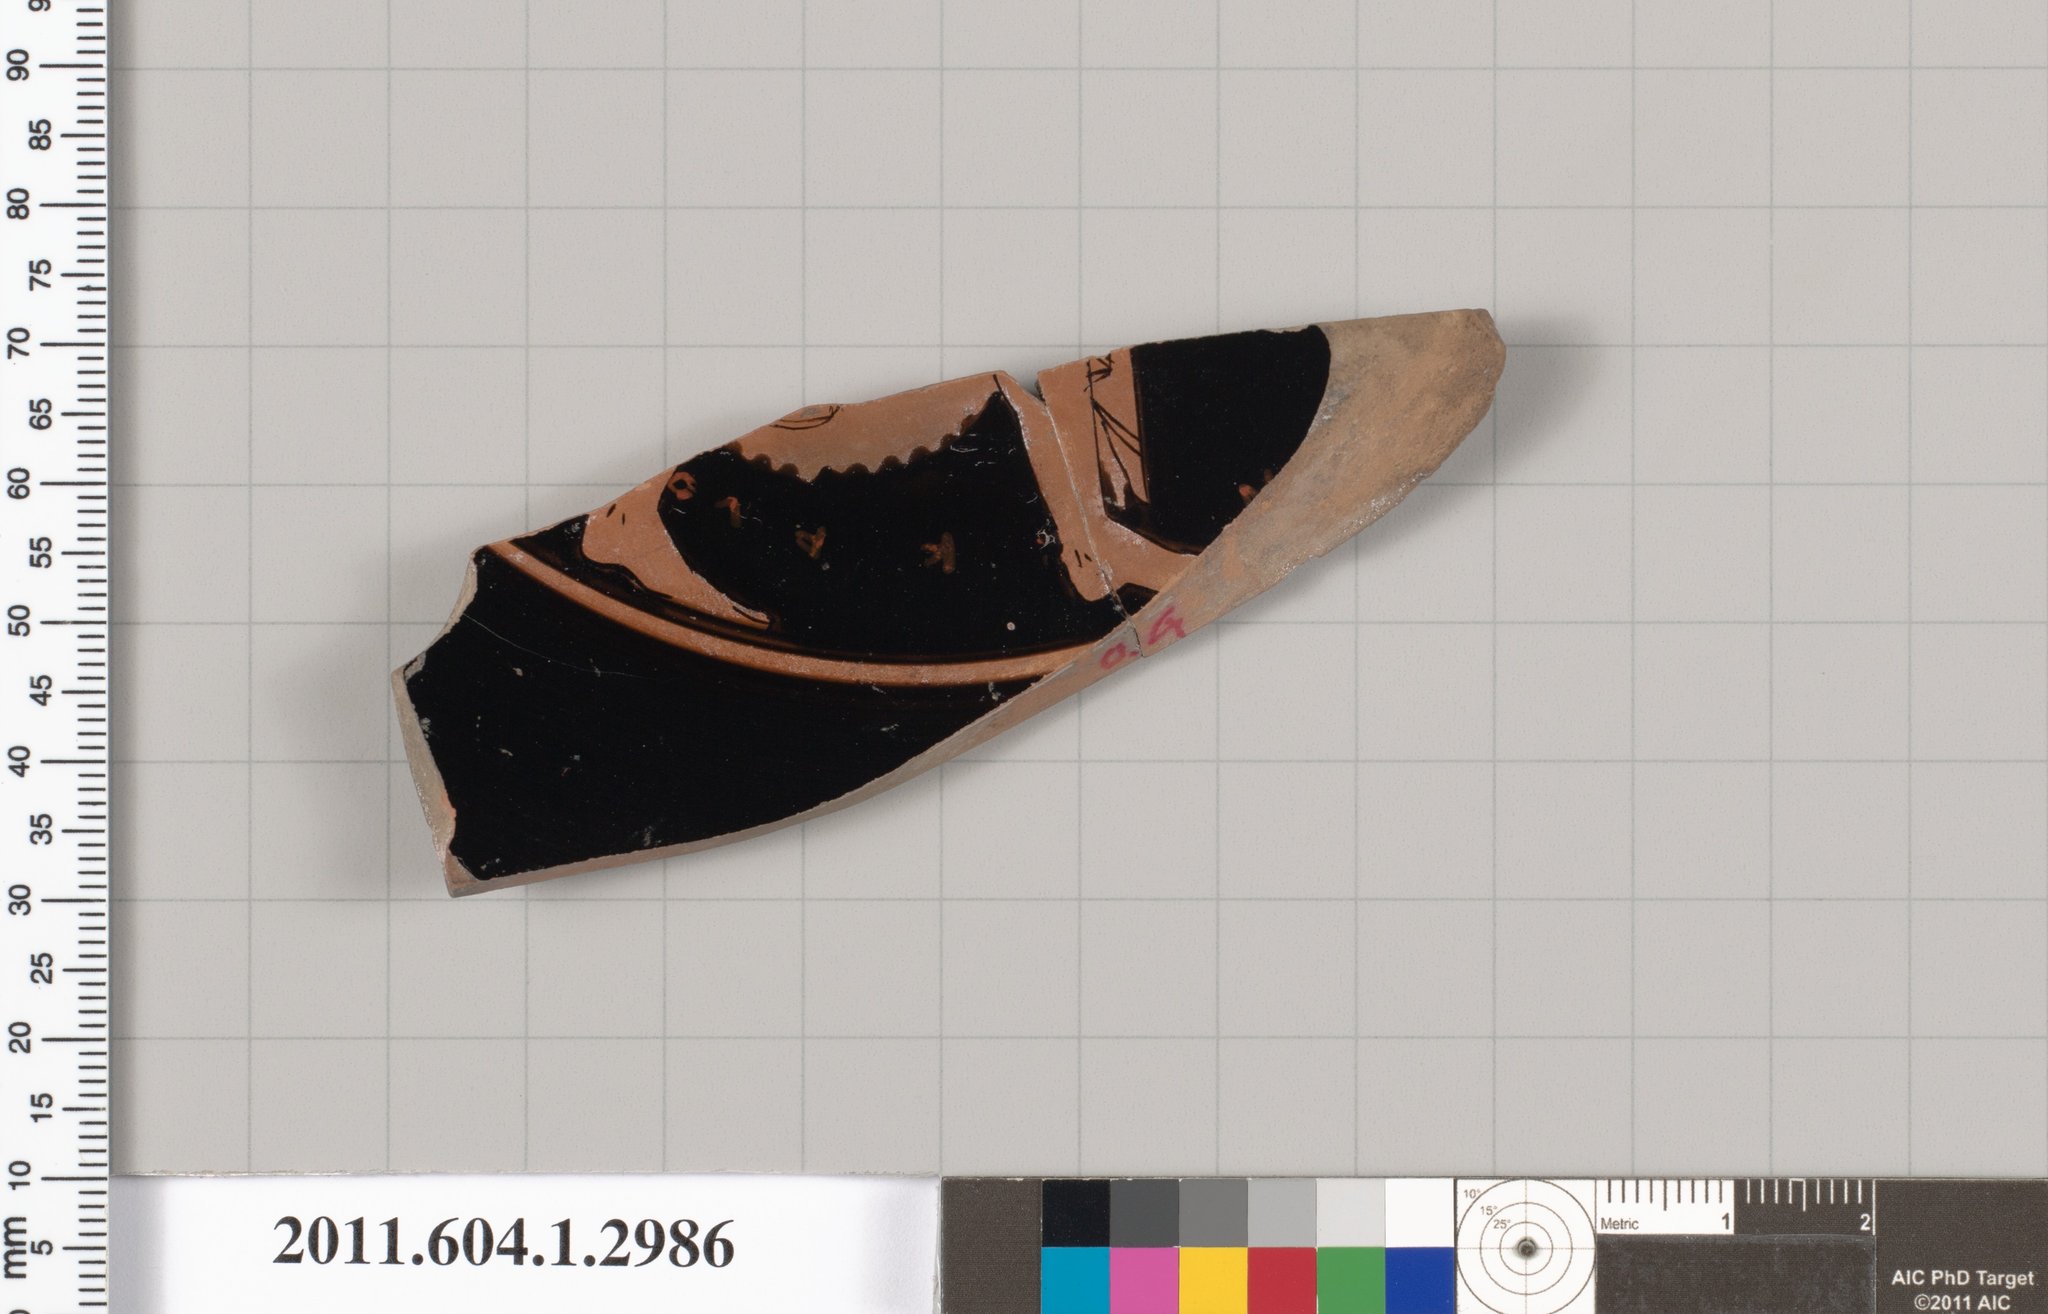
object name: kylix fragment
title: Terracotta fragment of a kylix (drinking cup)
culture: greek, attic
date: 520-500 BCE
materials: terracotta